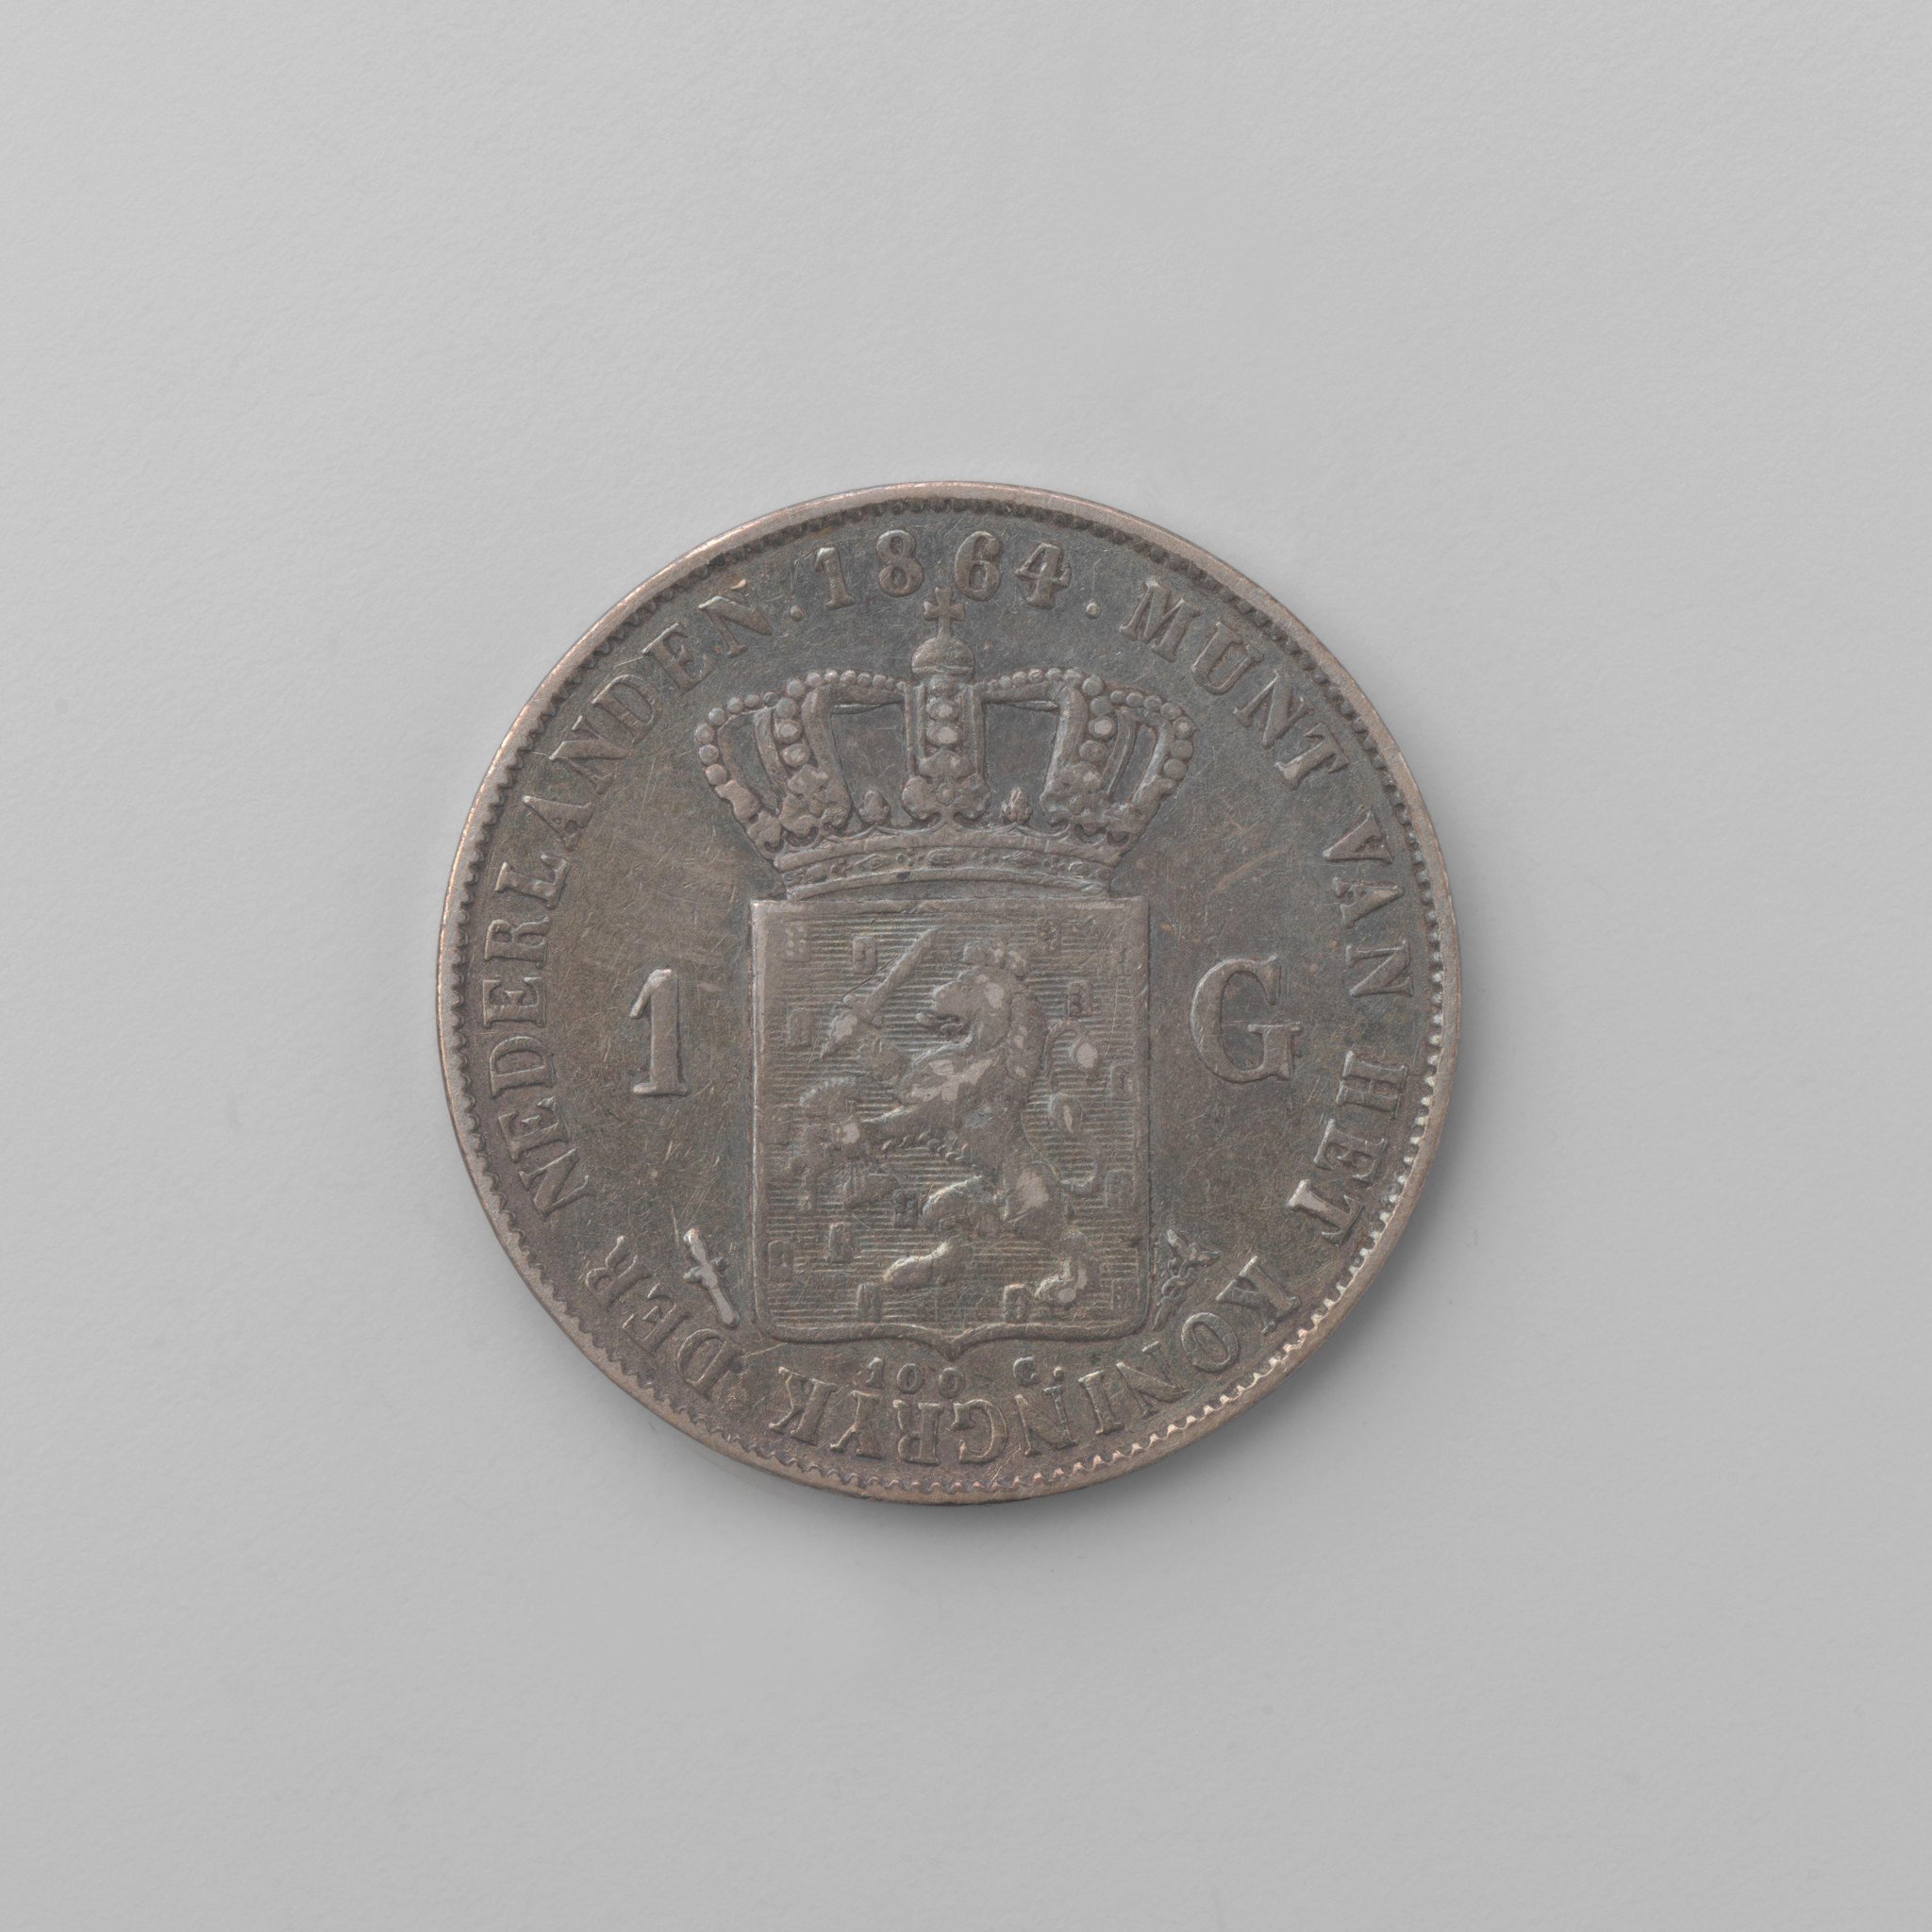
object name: coin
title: Nederlandse gulden, 1864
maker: willem iii (koning der nederlanden)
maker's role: koning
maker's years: 1817-1890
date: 1864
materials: silver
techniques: striking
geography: utrecht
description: Zilveren munt. Voorzijde: borstbeeld naar rechts. Keerzijde: tussen waarde-aanduiding 1 G gekroond rijkswapenschild. Jaartal boven kroon. Randschrift.